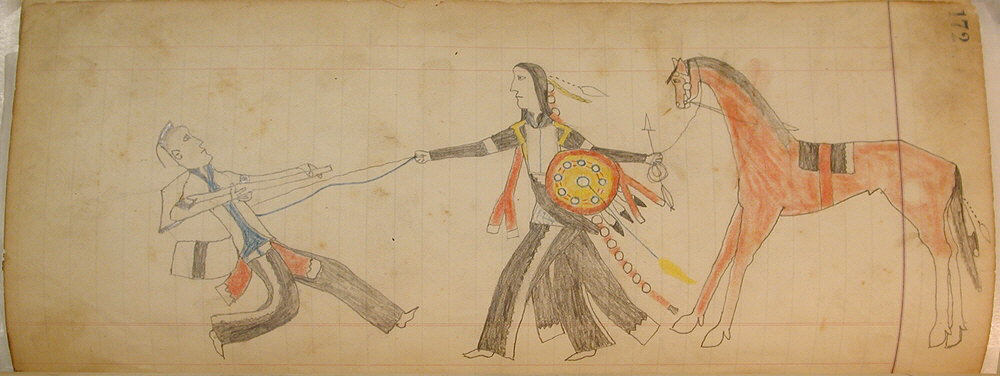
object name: drawing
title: Maffet Ledger: Drawing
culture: cheyenne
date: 1874-1881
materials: crayon, graphite, paper, watercolor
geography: united states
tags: men,women,horses